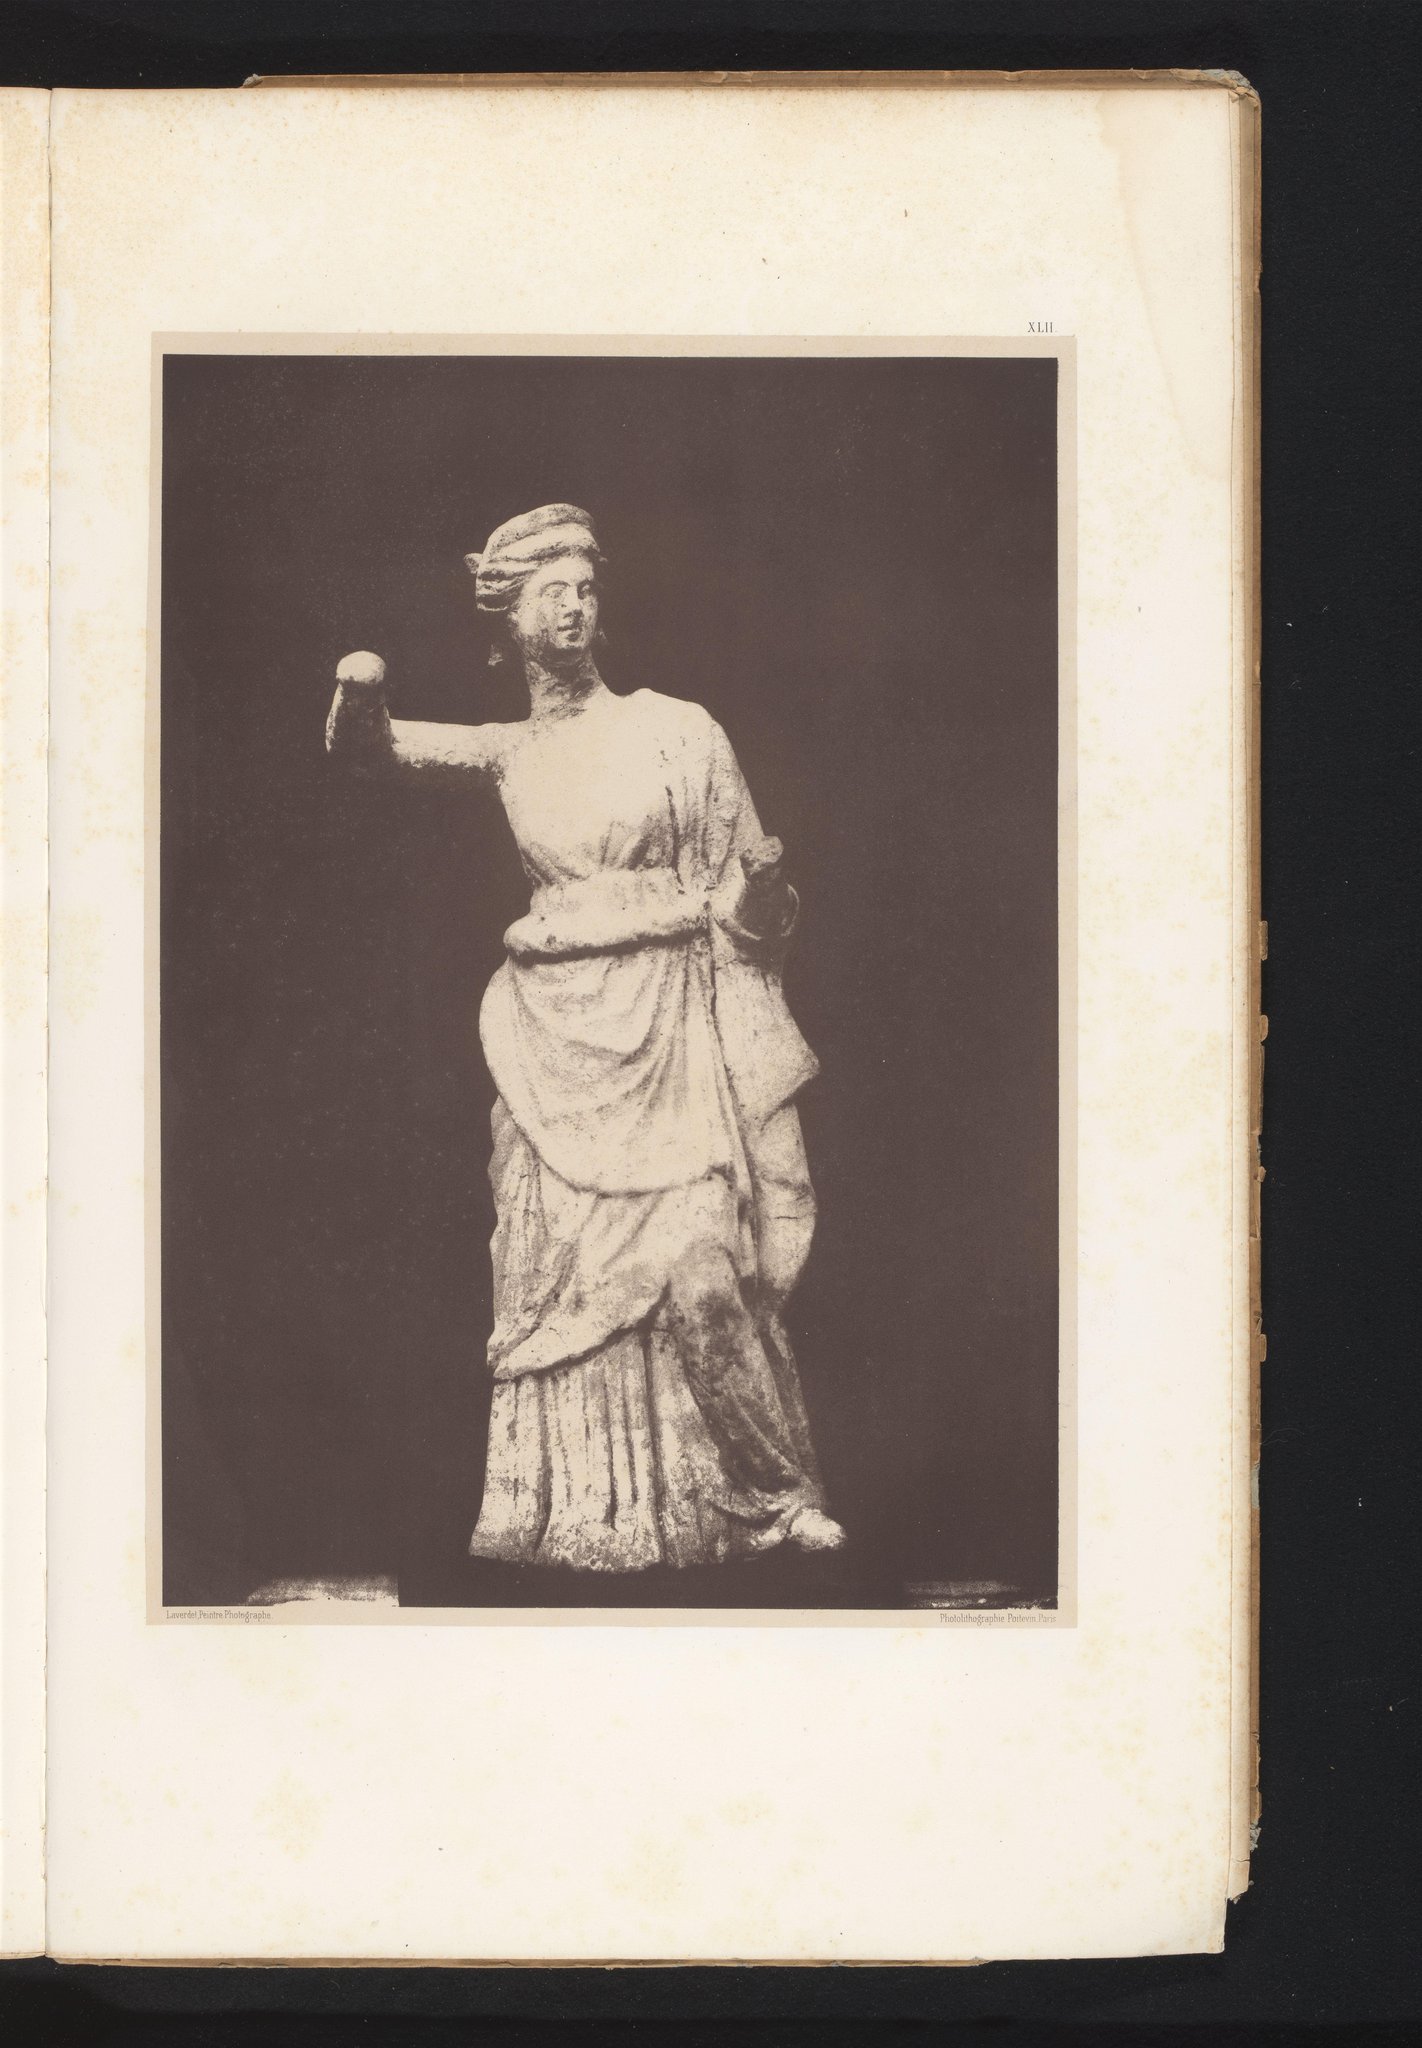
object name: photomechanical print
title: Terracotta sculptuur van Juno of Venus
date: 1852-1857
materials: paper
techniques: photolithography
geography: paris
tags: adult woman, piece of sculpture, reproduction of a piece of sculpture (+ clay, sand, etc. ~ arts)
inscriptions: number: ‘XLII.’